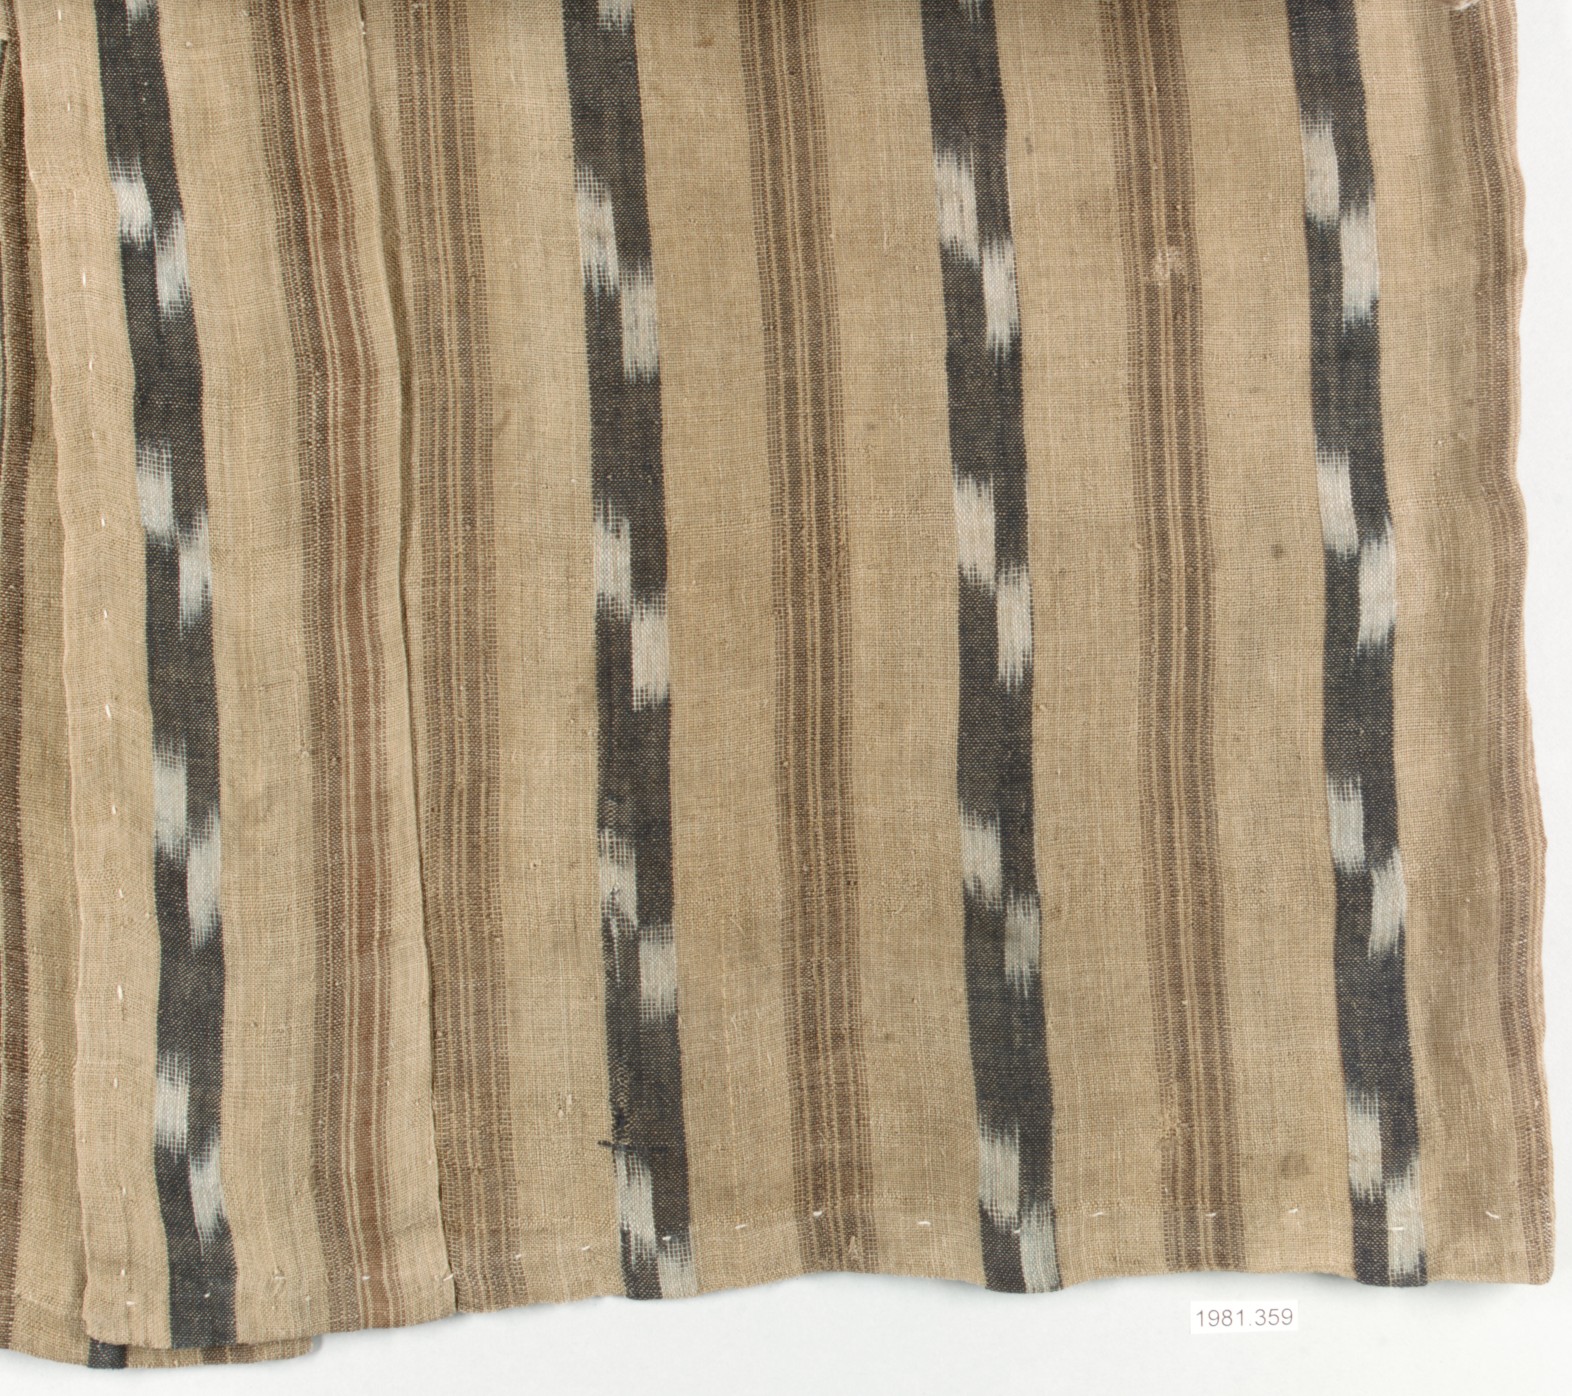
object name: robe, child's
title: Child's Robe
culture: japanese or ryukyuan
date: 1801-1900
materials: cotton, fiber